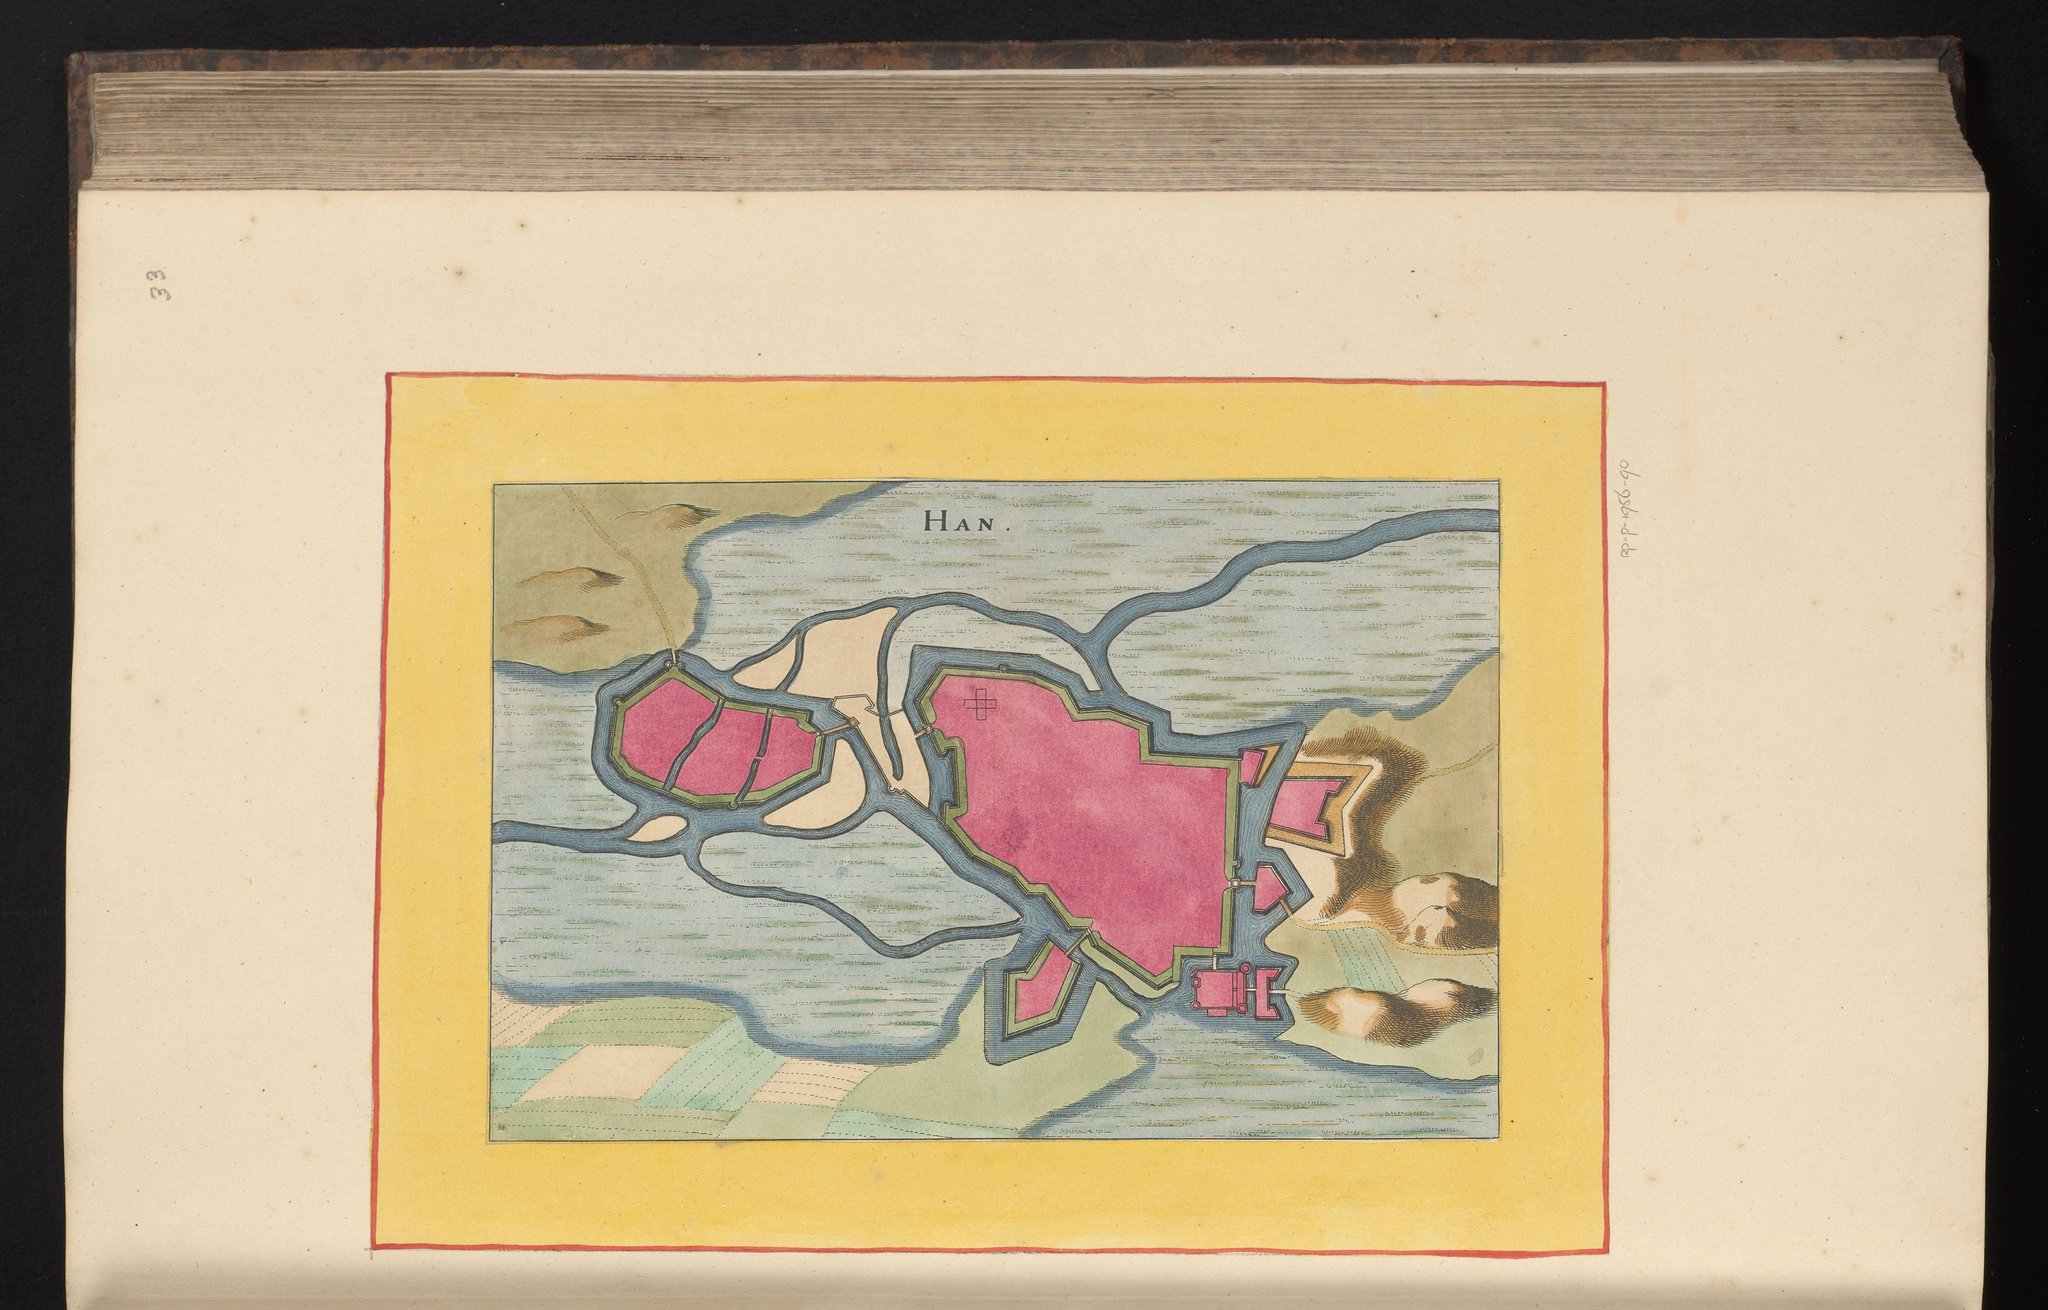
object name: print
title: Han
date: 1656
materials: paper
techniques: engraving, etching, hand coloring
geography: frankfurt am main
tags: maps of cities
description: Prent uit: Zeiller, Martin. Topographia Galliae. 13 dln. Frankfurt: Caspar Merian, 1656, dl. 2, na p. 22.